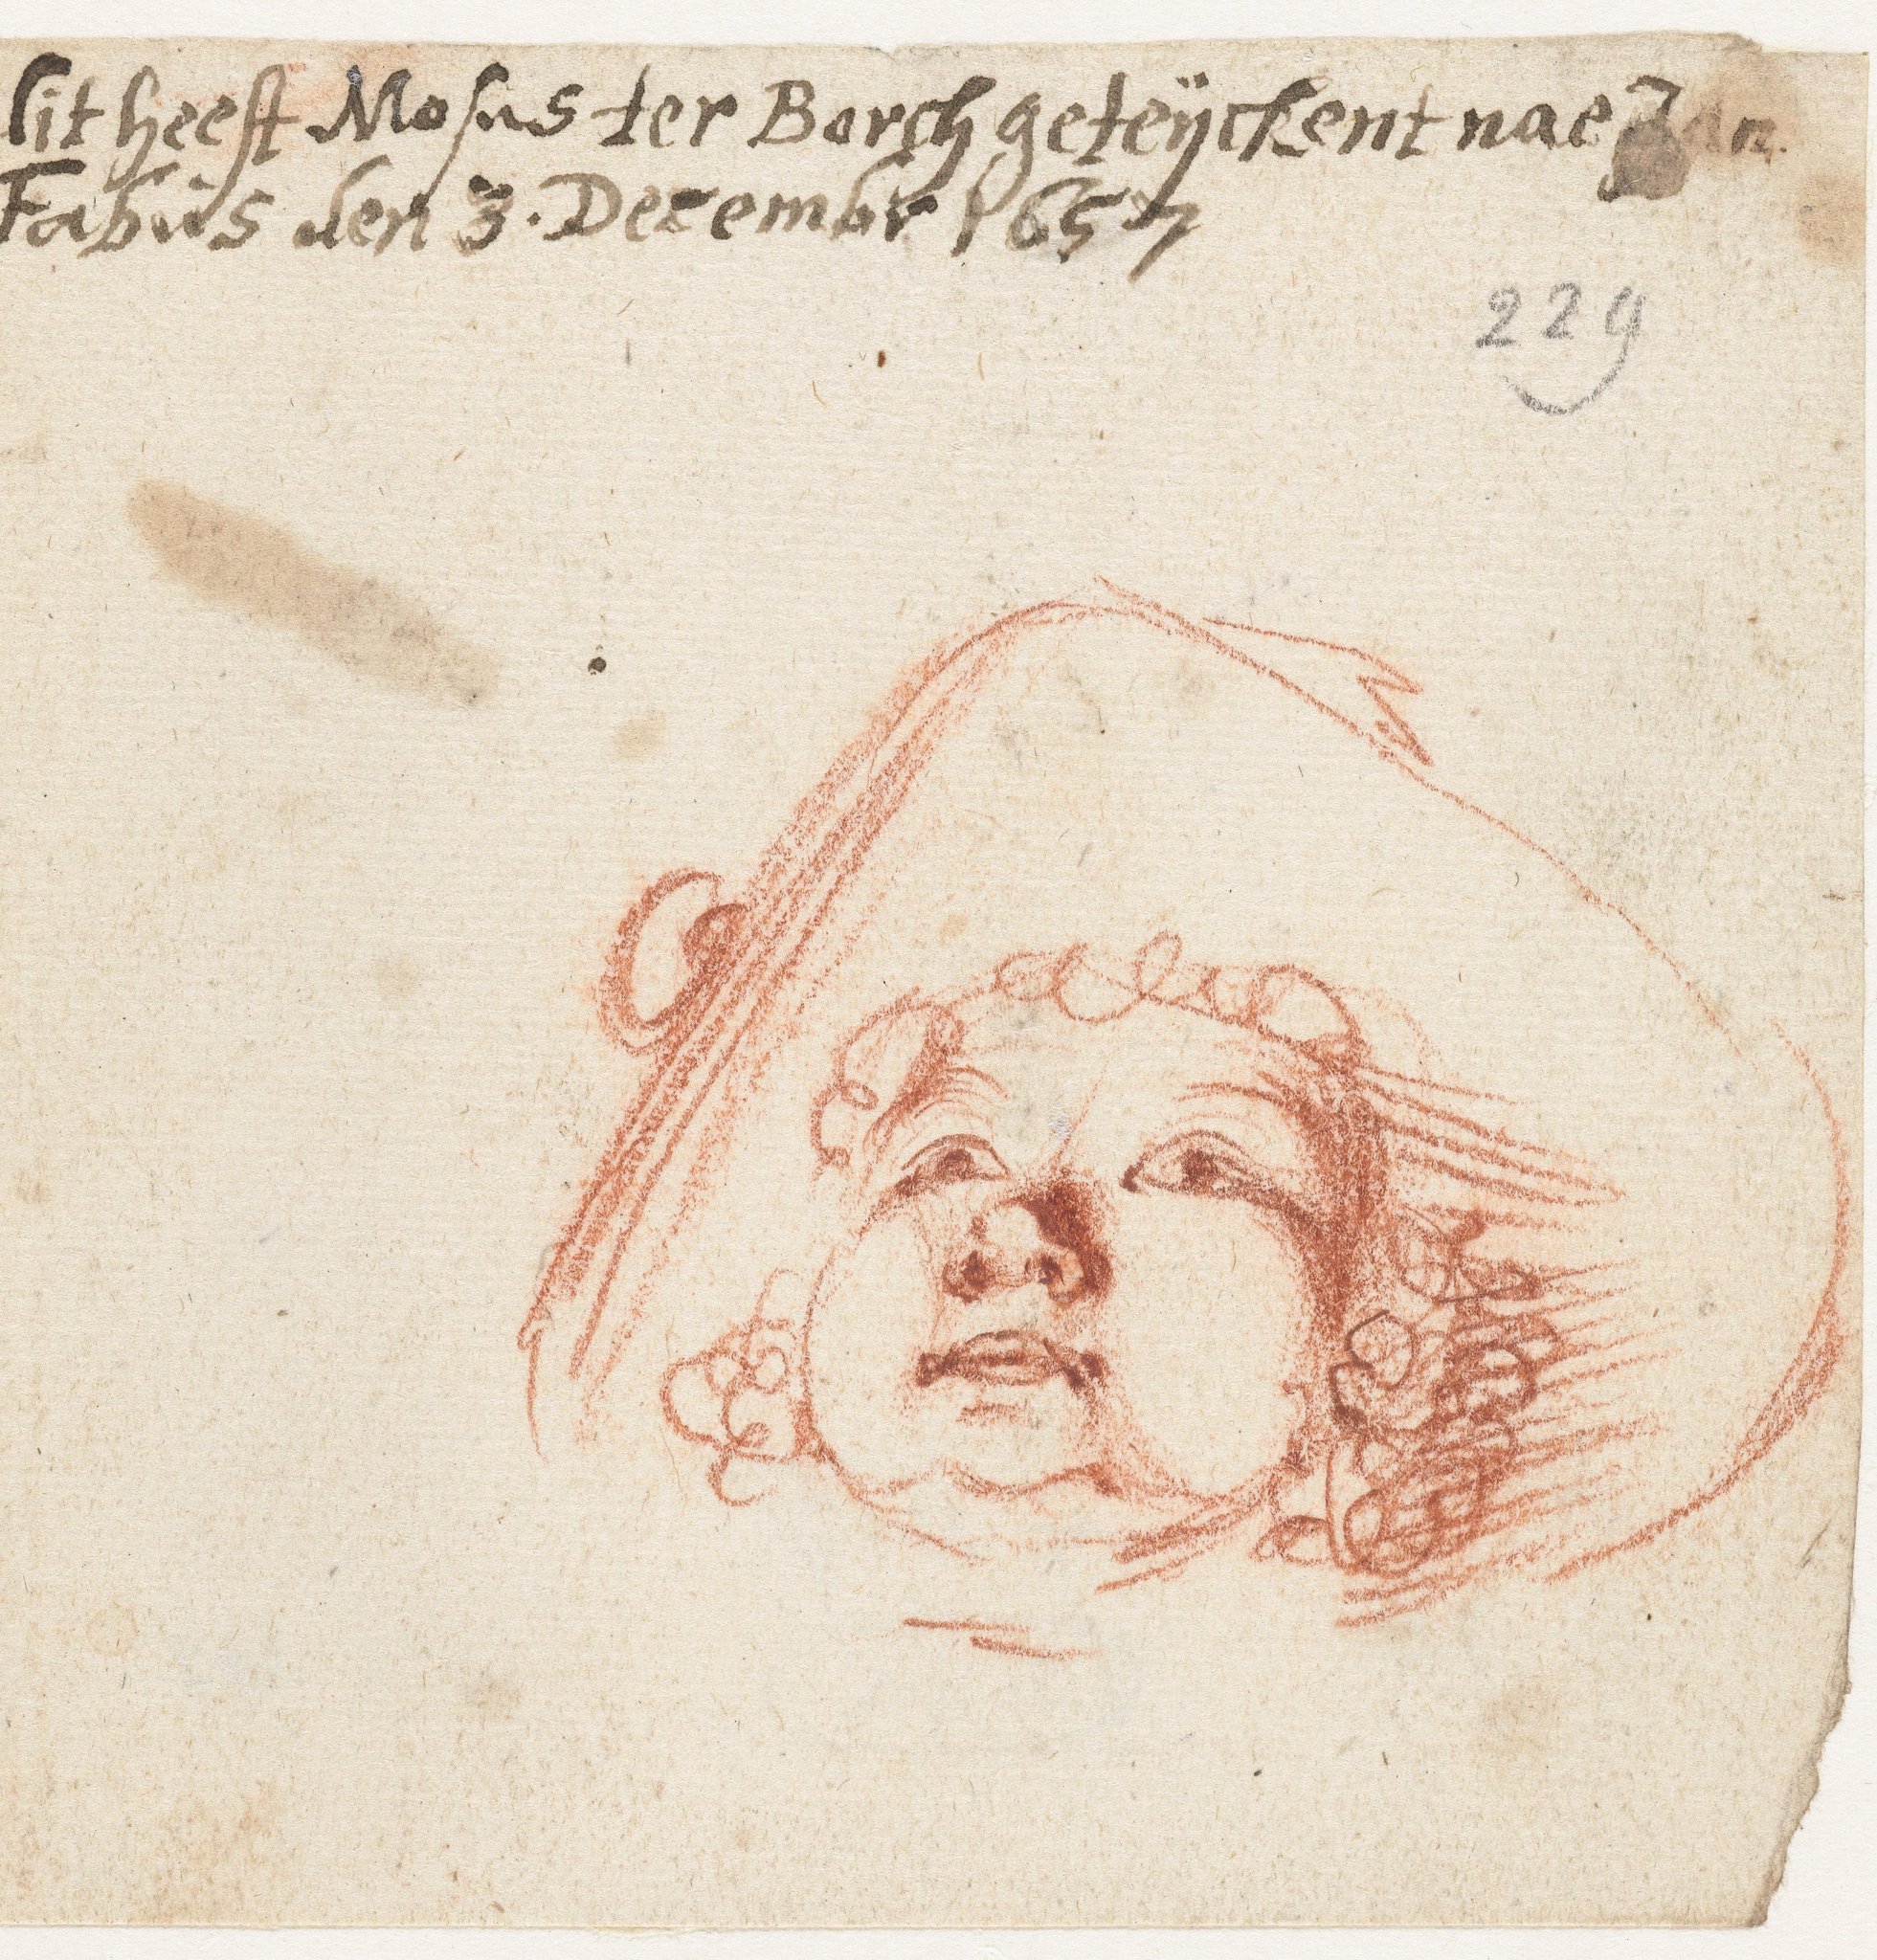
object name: drawing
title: Portretstudie van Jan Fabius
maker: moses ter borch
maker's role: draughtsman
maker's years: 1645-1667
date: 1657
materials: chalk, paper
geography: zwolle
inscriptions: annotation: ‘dit heeft Mosus ter Borch geteijckent nae Jan/ Fabus den 3.Decembr 1657’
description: Portretstudie van Jan Fabius (geboren in 1651, gestorven voor 1664) op 6- of 7-jarige leeftijd.